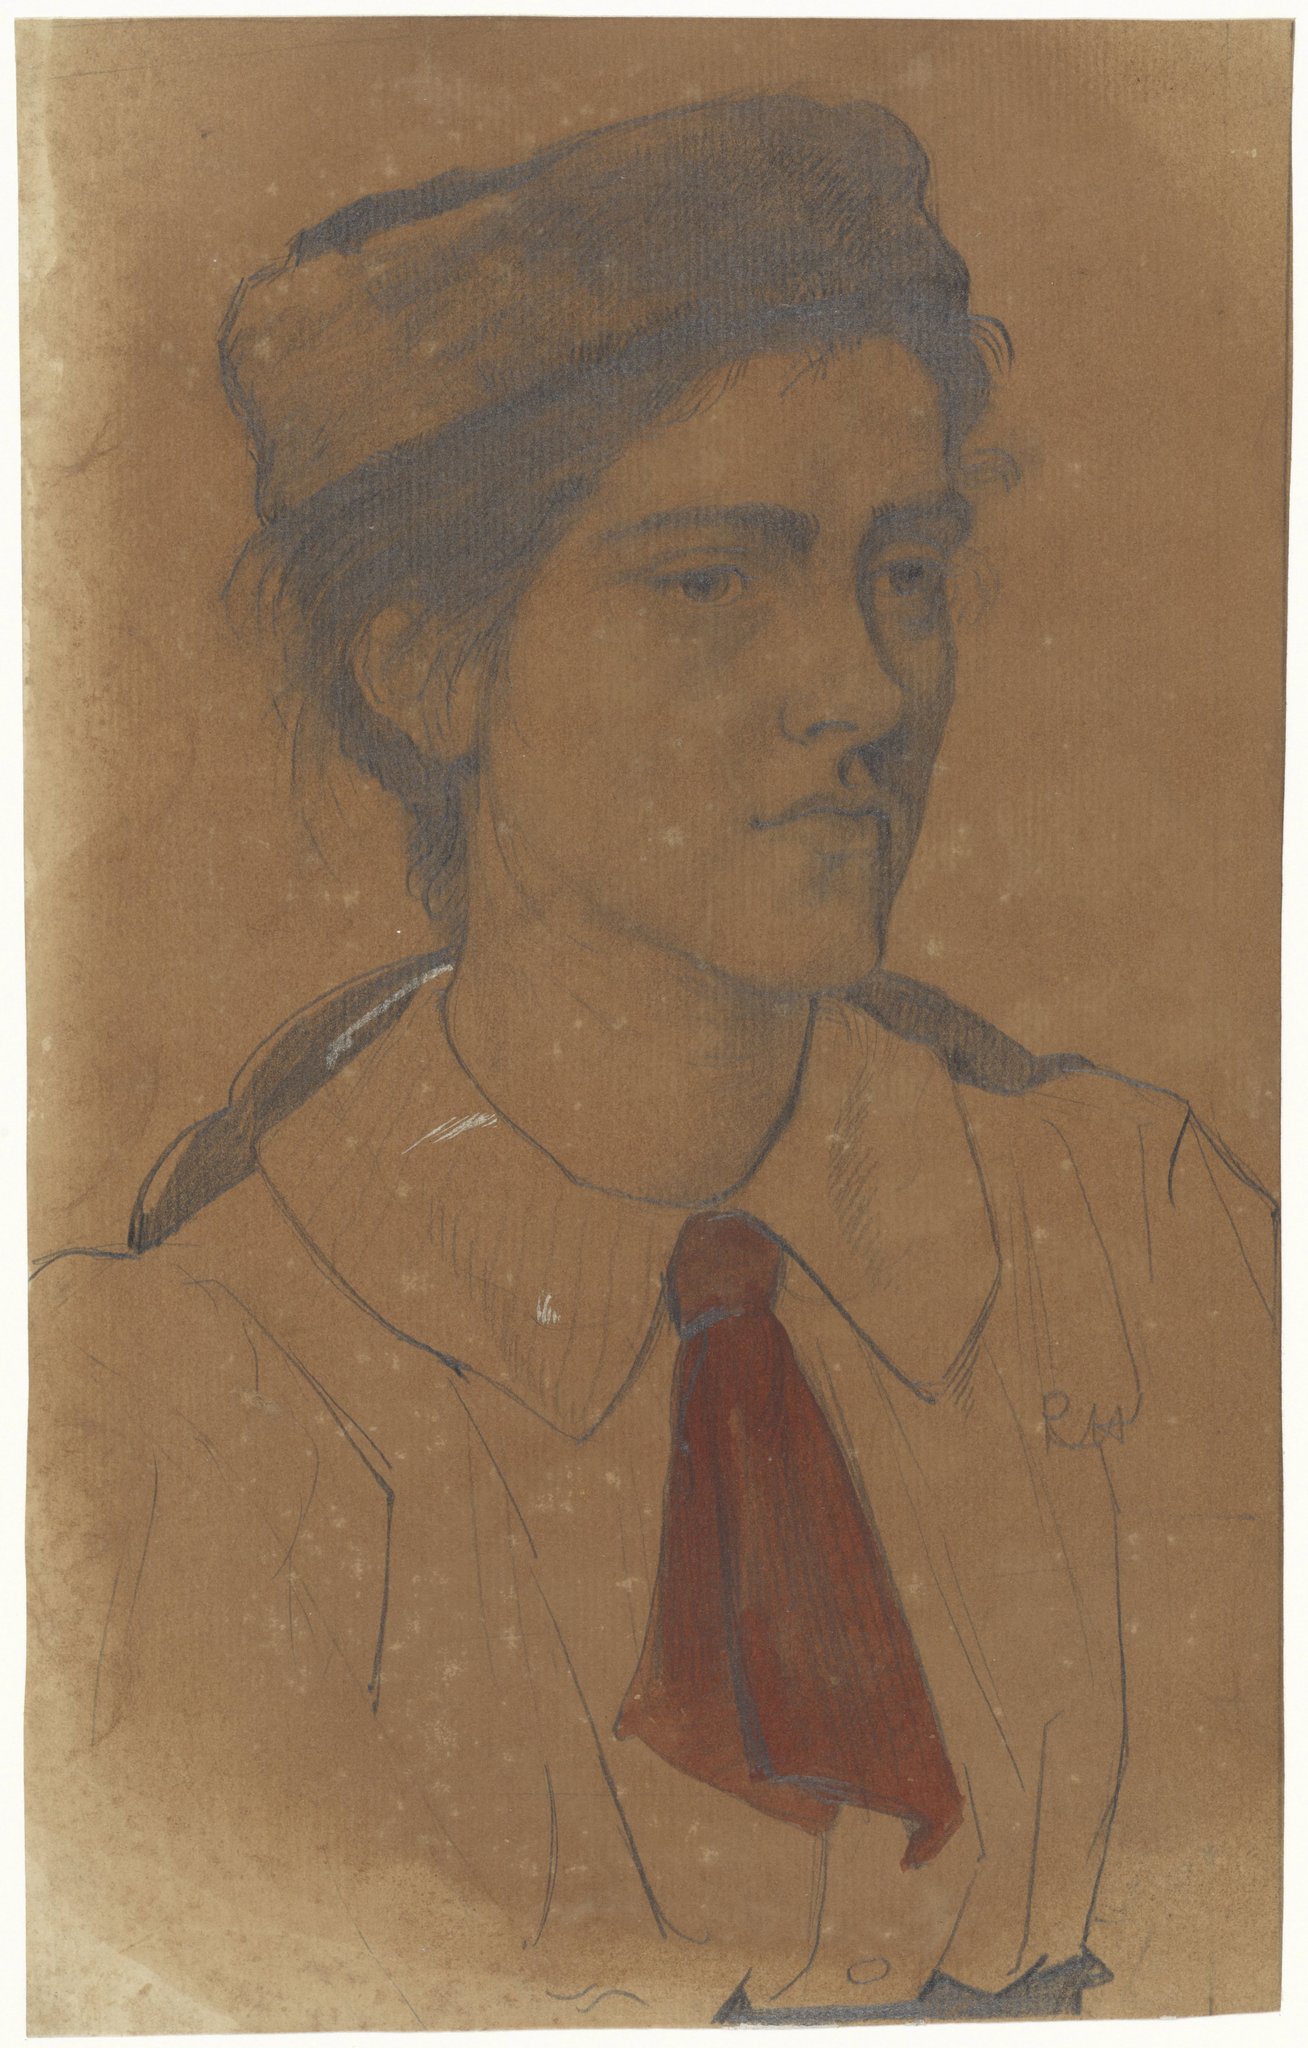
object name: drawing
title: Portret van Kootje Martinet uit Loenen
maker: richard nicolaüs roland holst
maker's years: 1868-1938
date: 1878-1938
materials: pencil, paper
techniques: brush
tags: historical persons